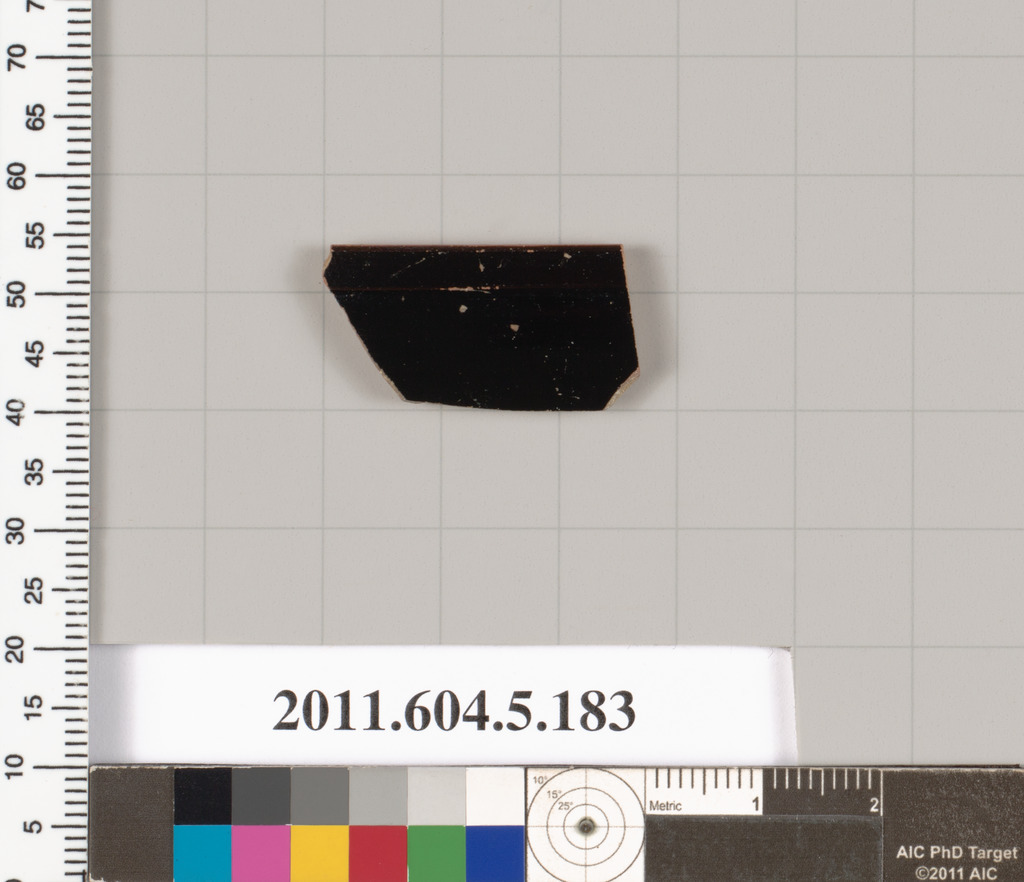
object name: kylix fragment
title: Terracotta rim fragment of a kylix (drinking cup)?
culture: greek, attic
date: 500-401 BCE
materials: terracotta